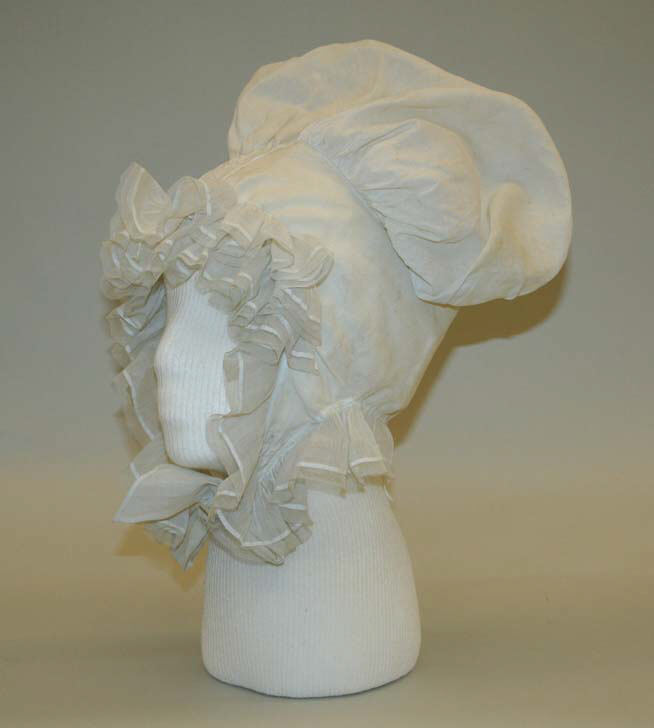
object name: mobcap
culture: american or european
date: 1801-1833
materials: linen